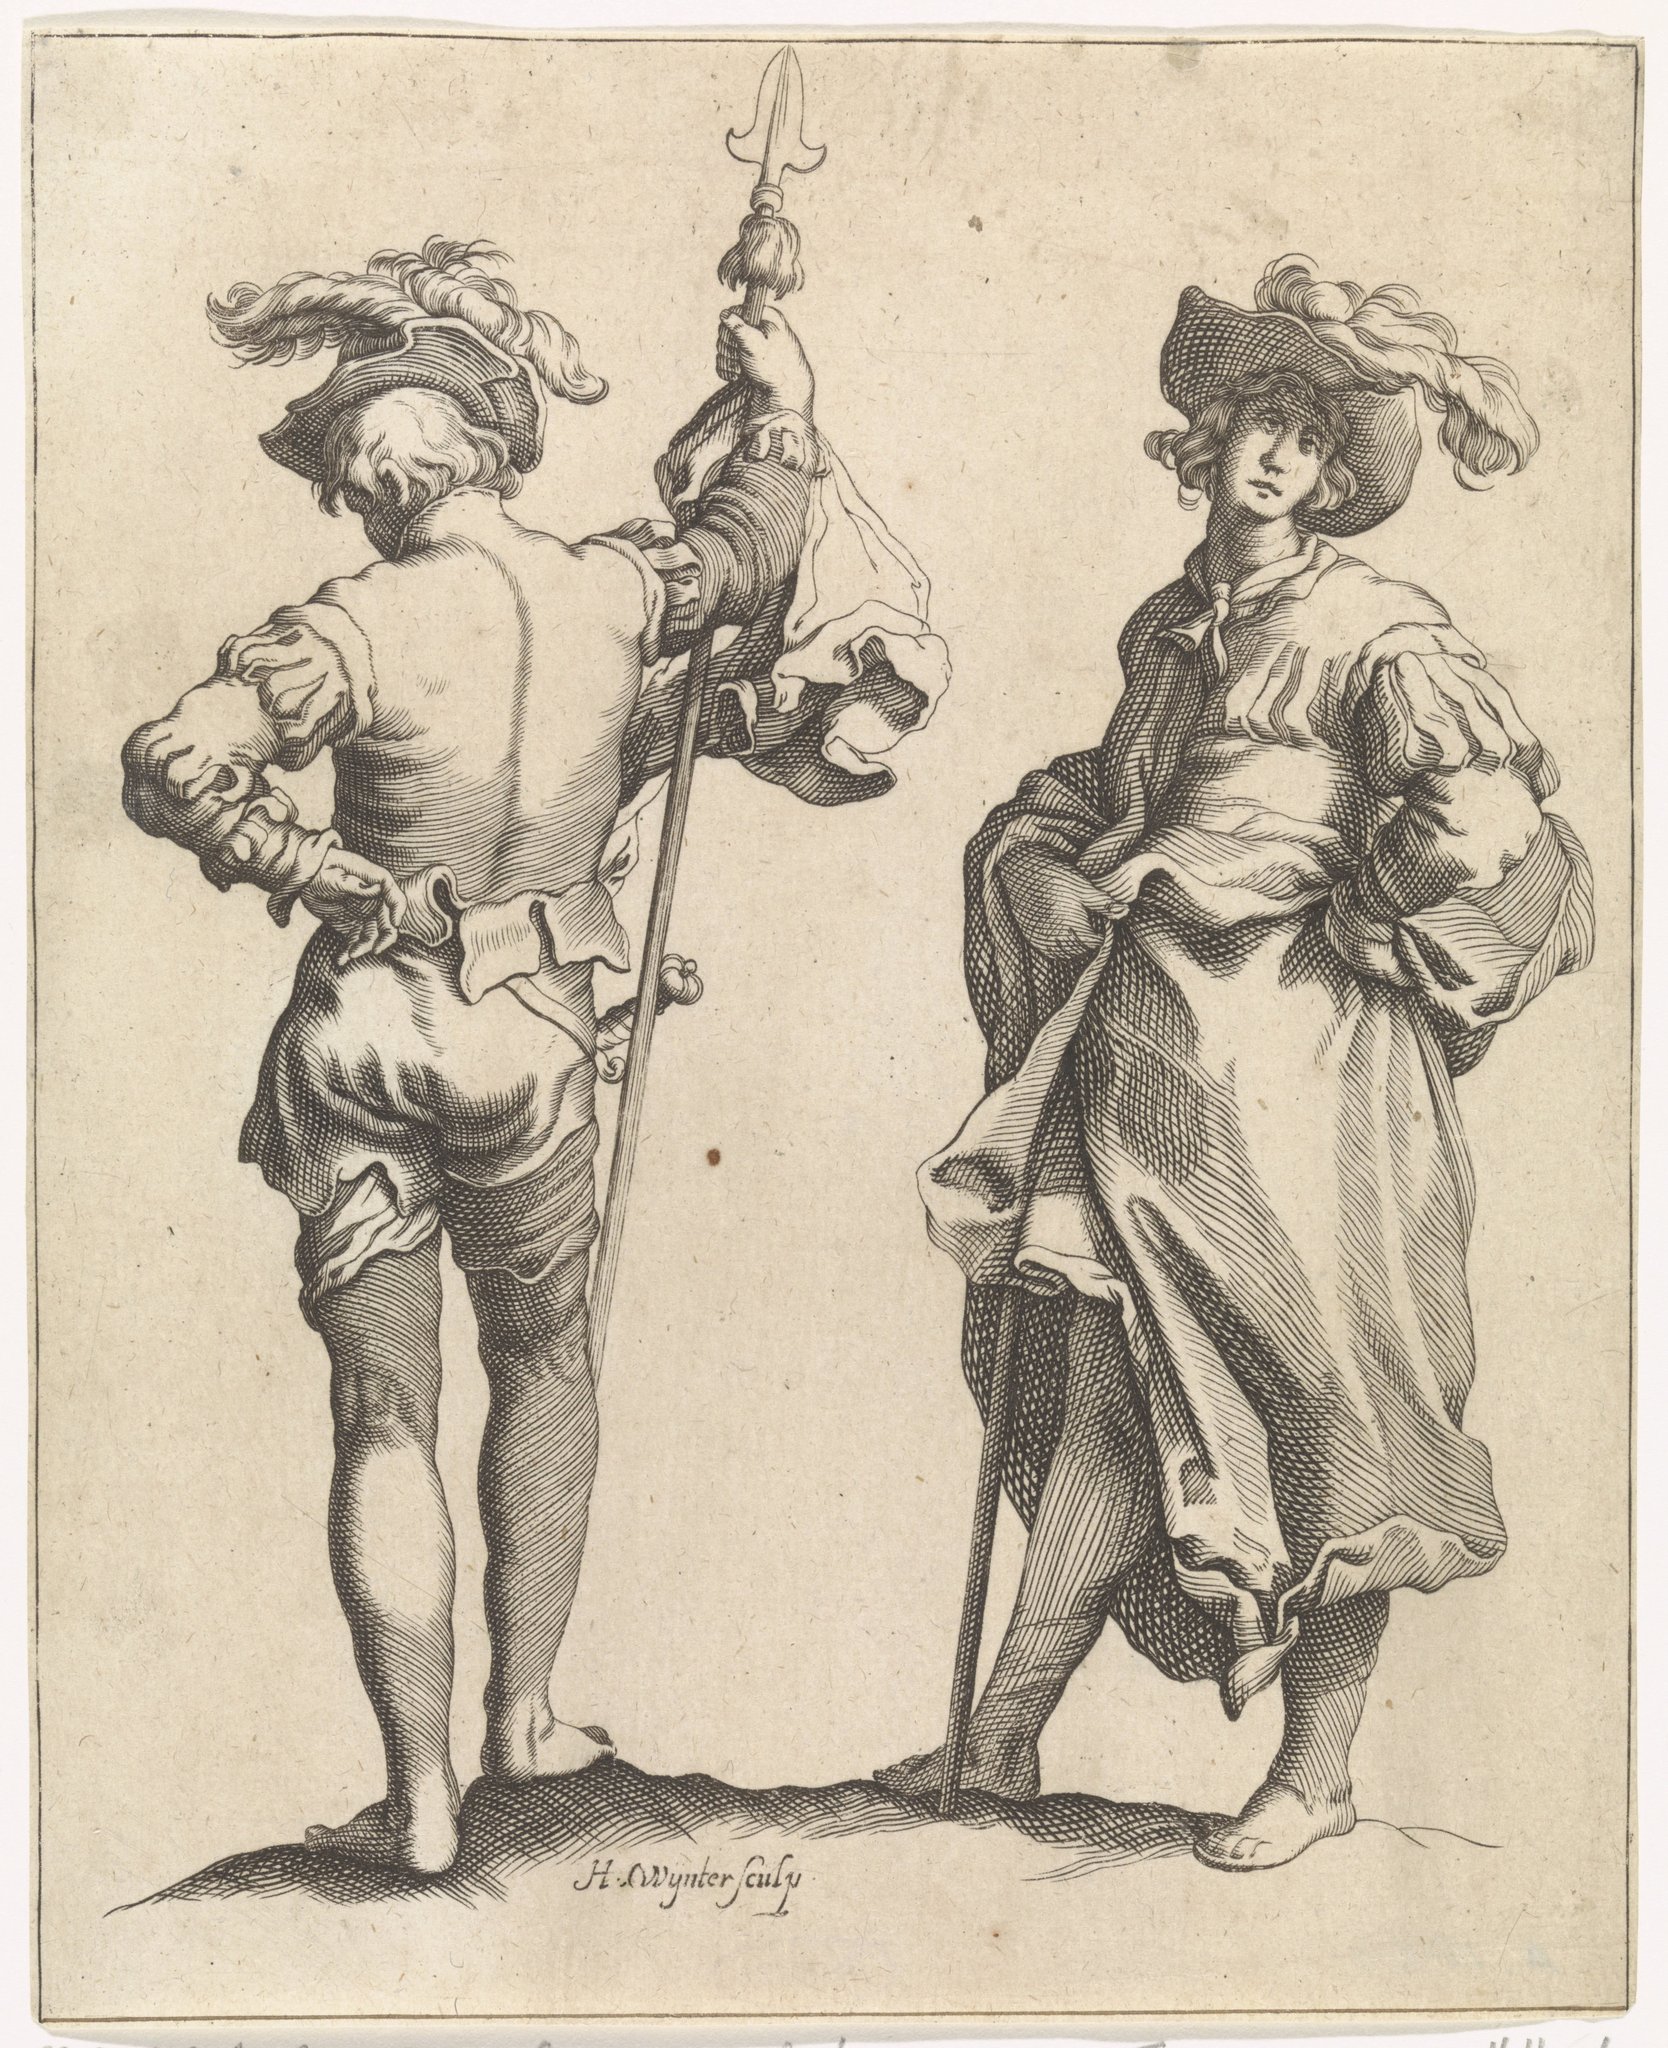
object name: print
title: Twee soldaten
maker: hendrik winter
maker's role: jeweler, print maker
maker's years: 1620-1677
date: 1630-1677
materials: paper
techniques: engraving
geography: utrecht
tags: the soldier; the soldier's life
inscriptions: collector's mark: Lugt 2228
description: Twee soldaten. Links een piekenier op de rug gezien. Rechts een soldaat met een hoed met pluim op het hoofd.